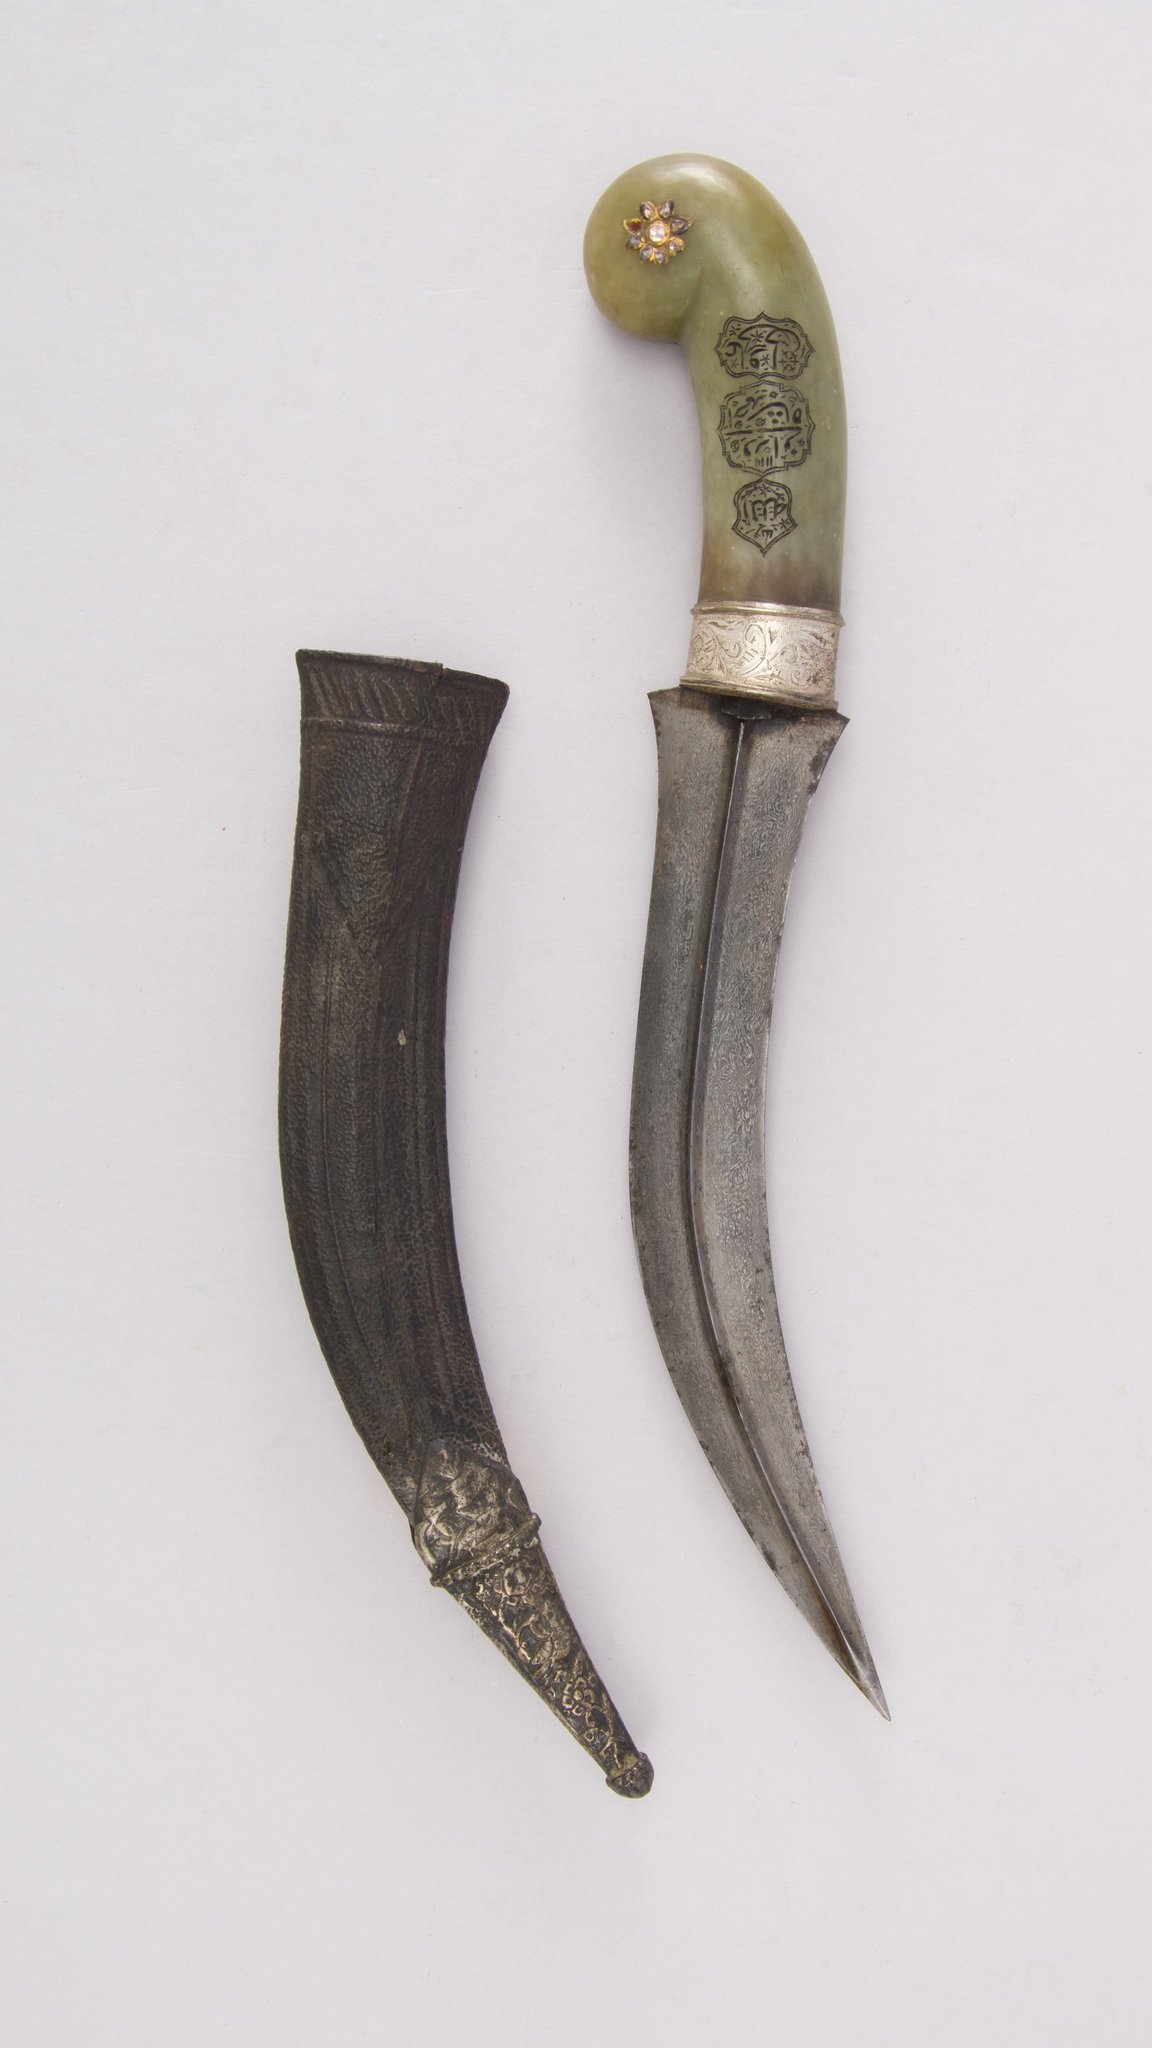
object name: dagger jambiya with sheath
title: Dagger (Jambiya) with Sheath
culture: indian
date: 1701-1800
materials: diamond, gold, jade, leather, silver, steel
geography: india